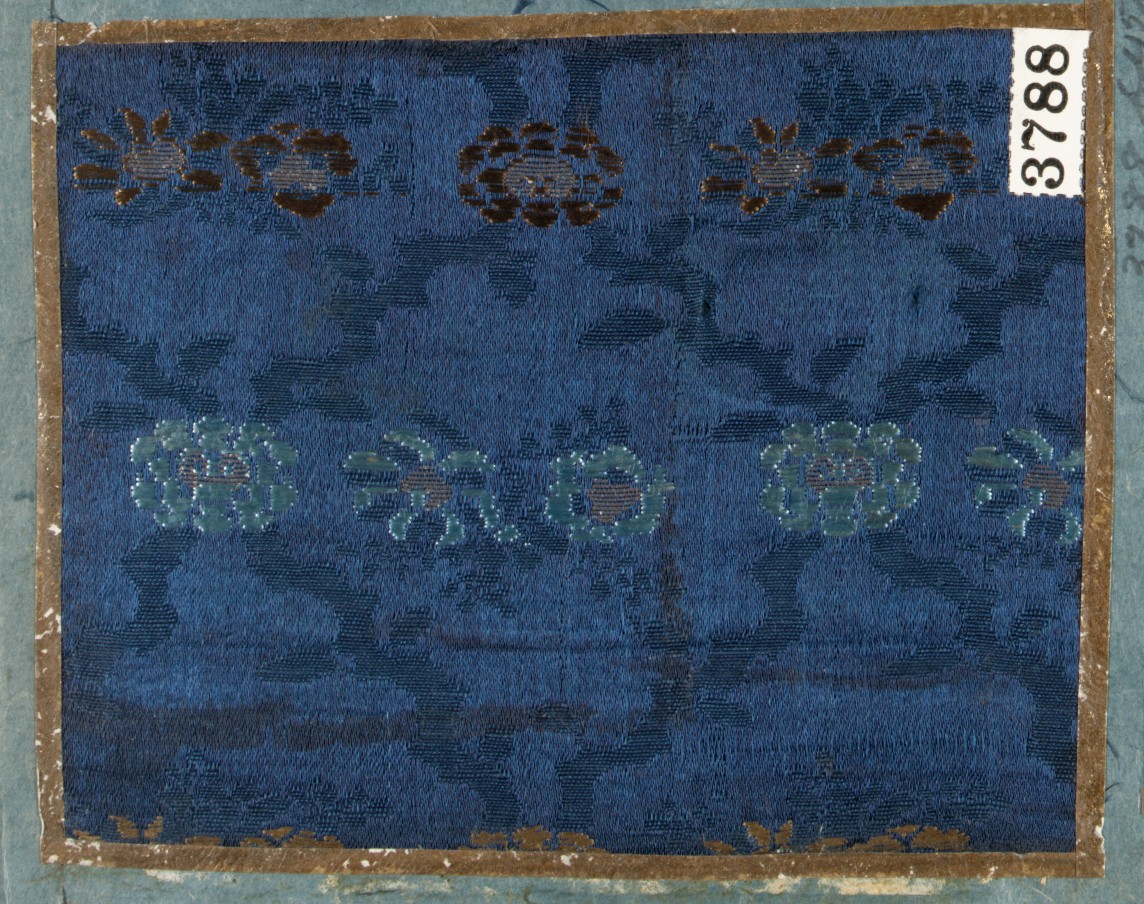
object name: sample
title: Textile Sample from Sample Book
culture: japanese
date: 1801-1900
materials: silk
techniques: tapestry